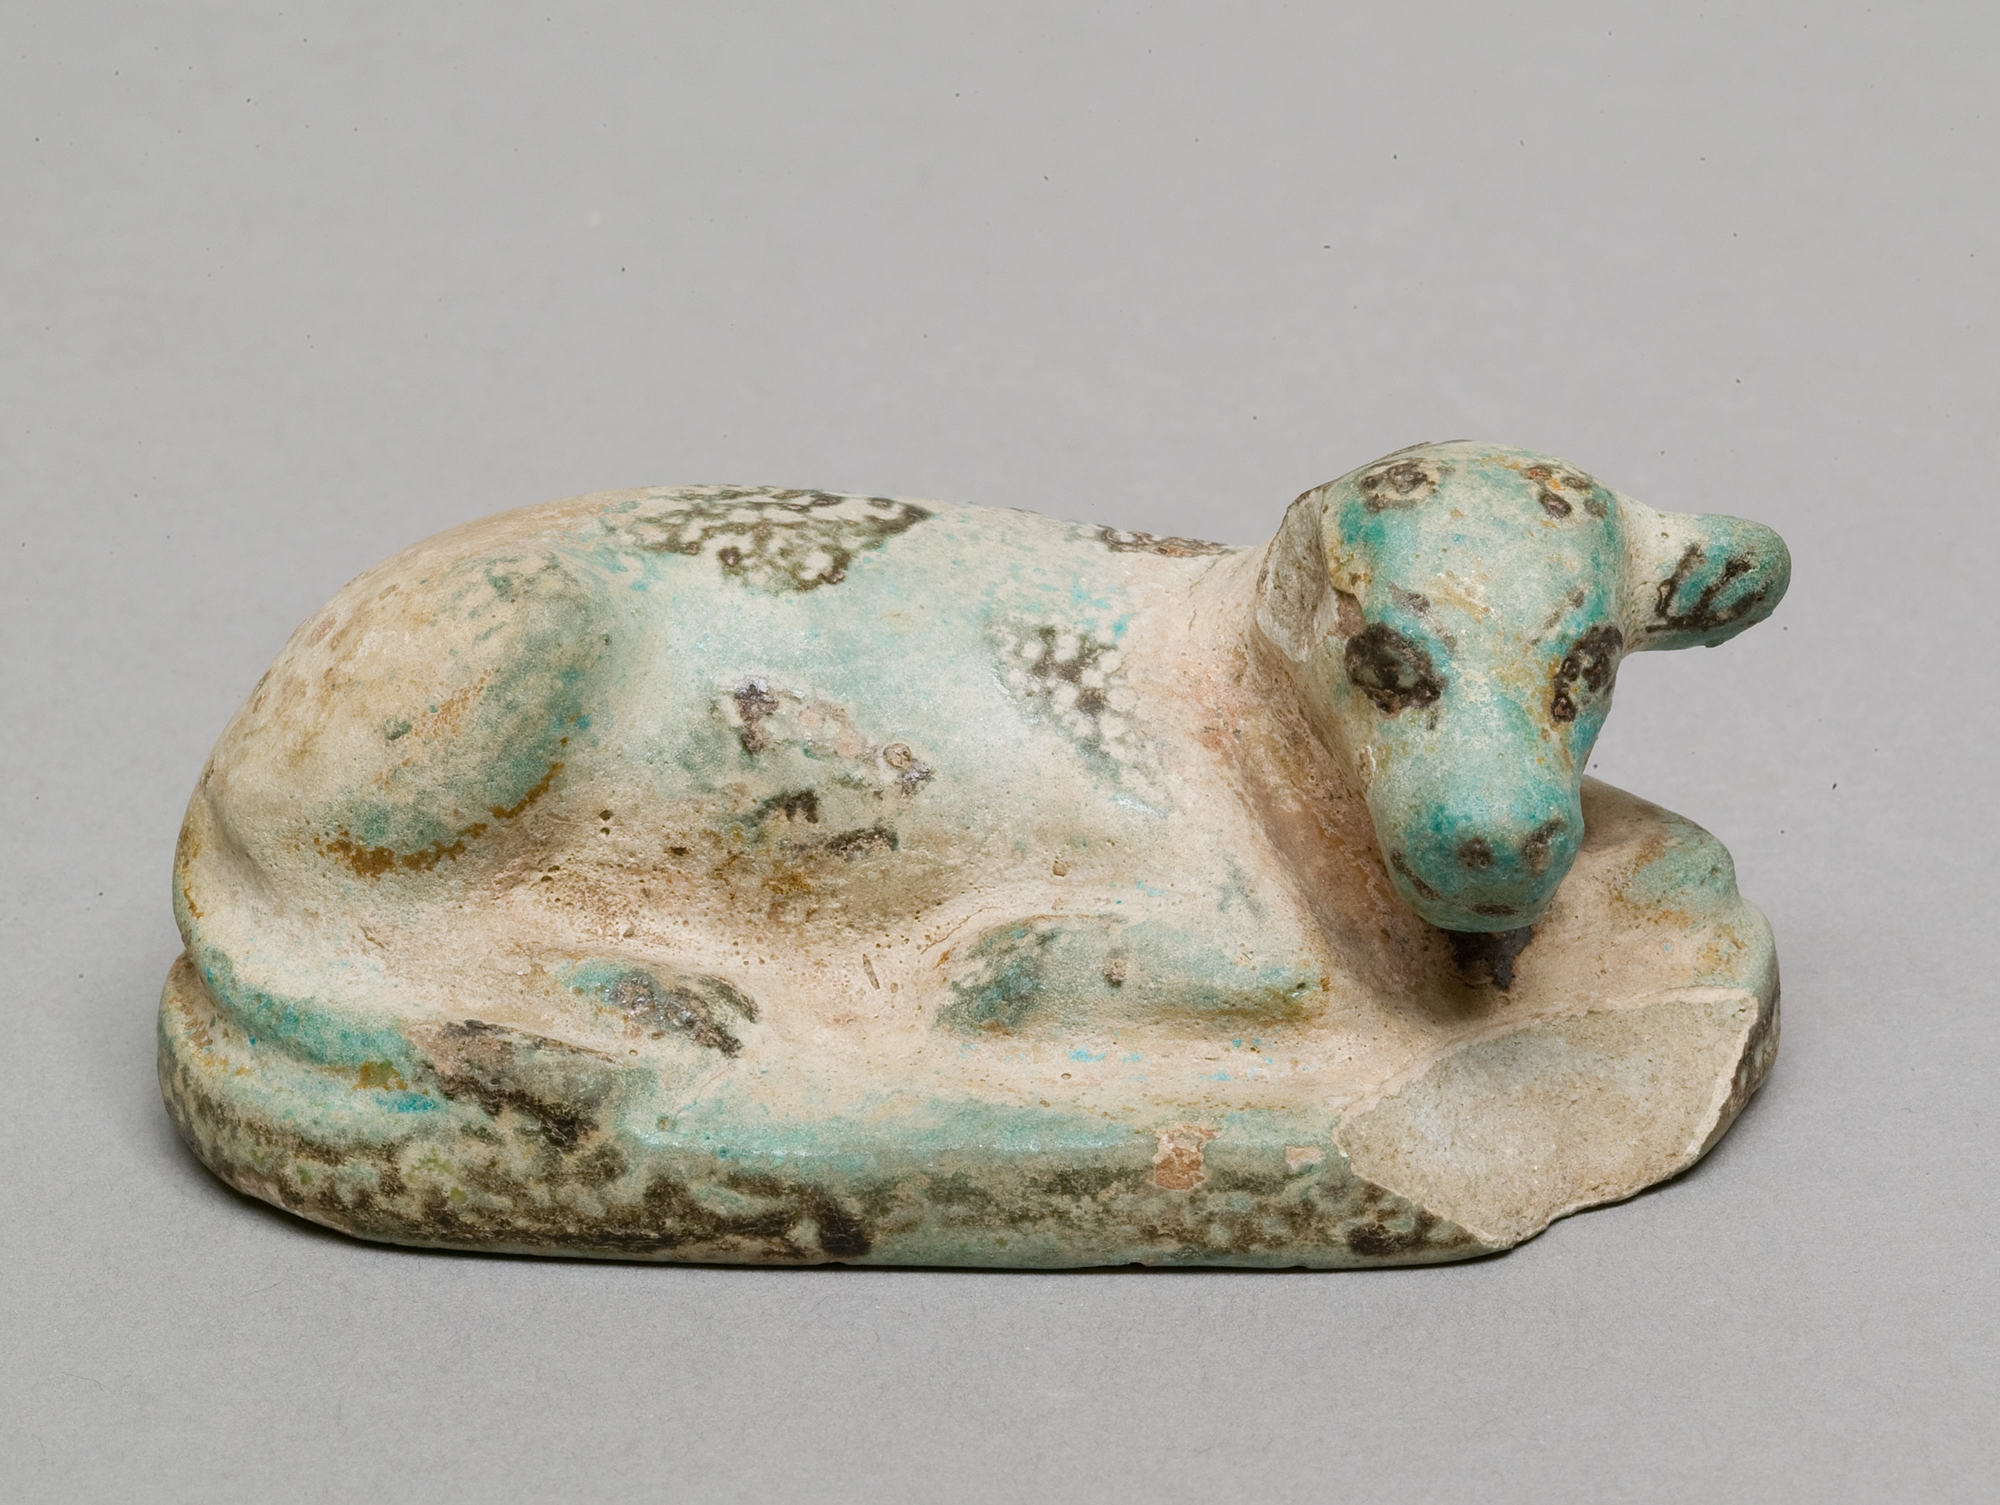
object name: figurine, calf recumbent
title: Figurine of a recumbent calf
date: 1981-1550 BCE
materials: faience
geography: egypt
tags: animals